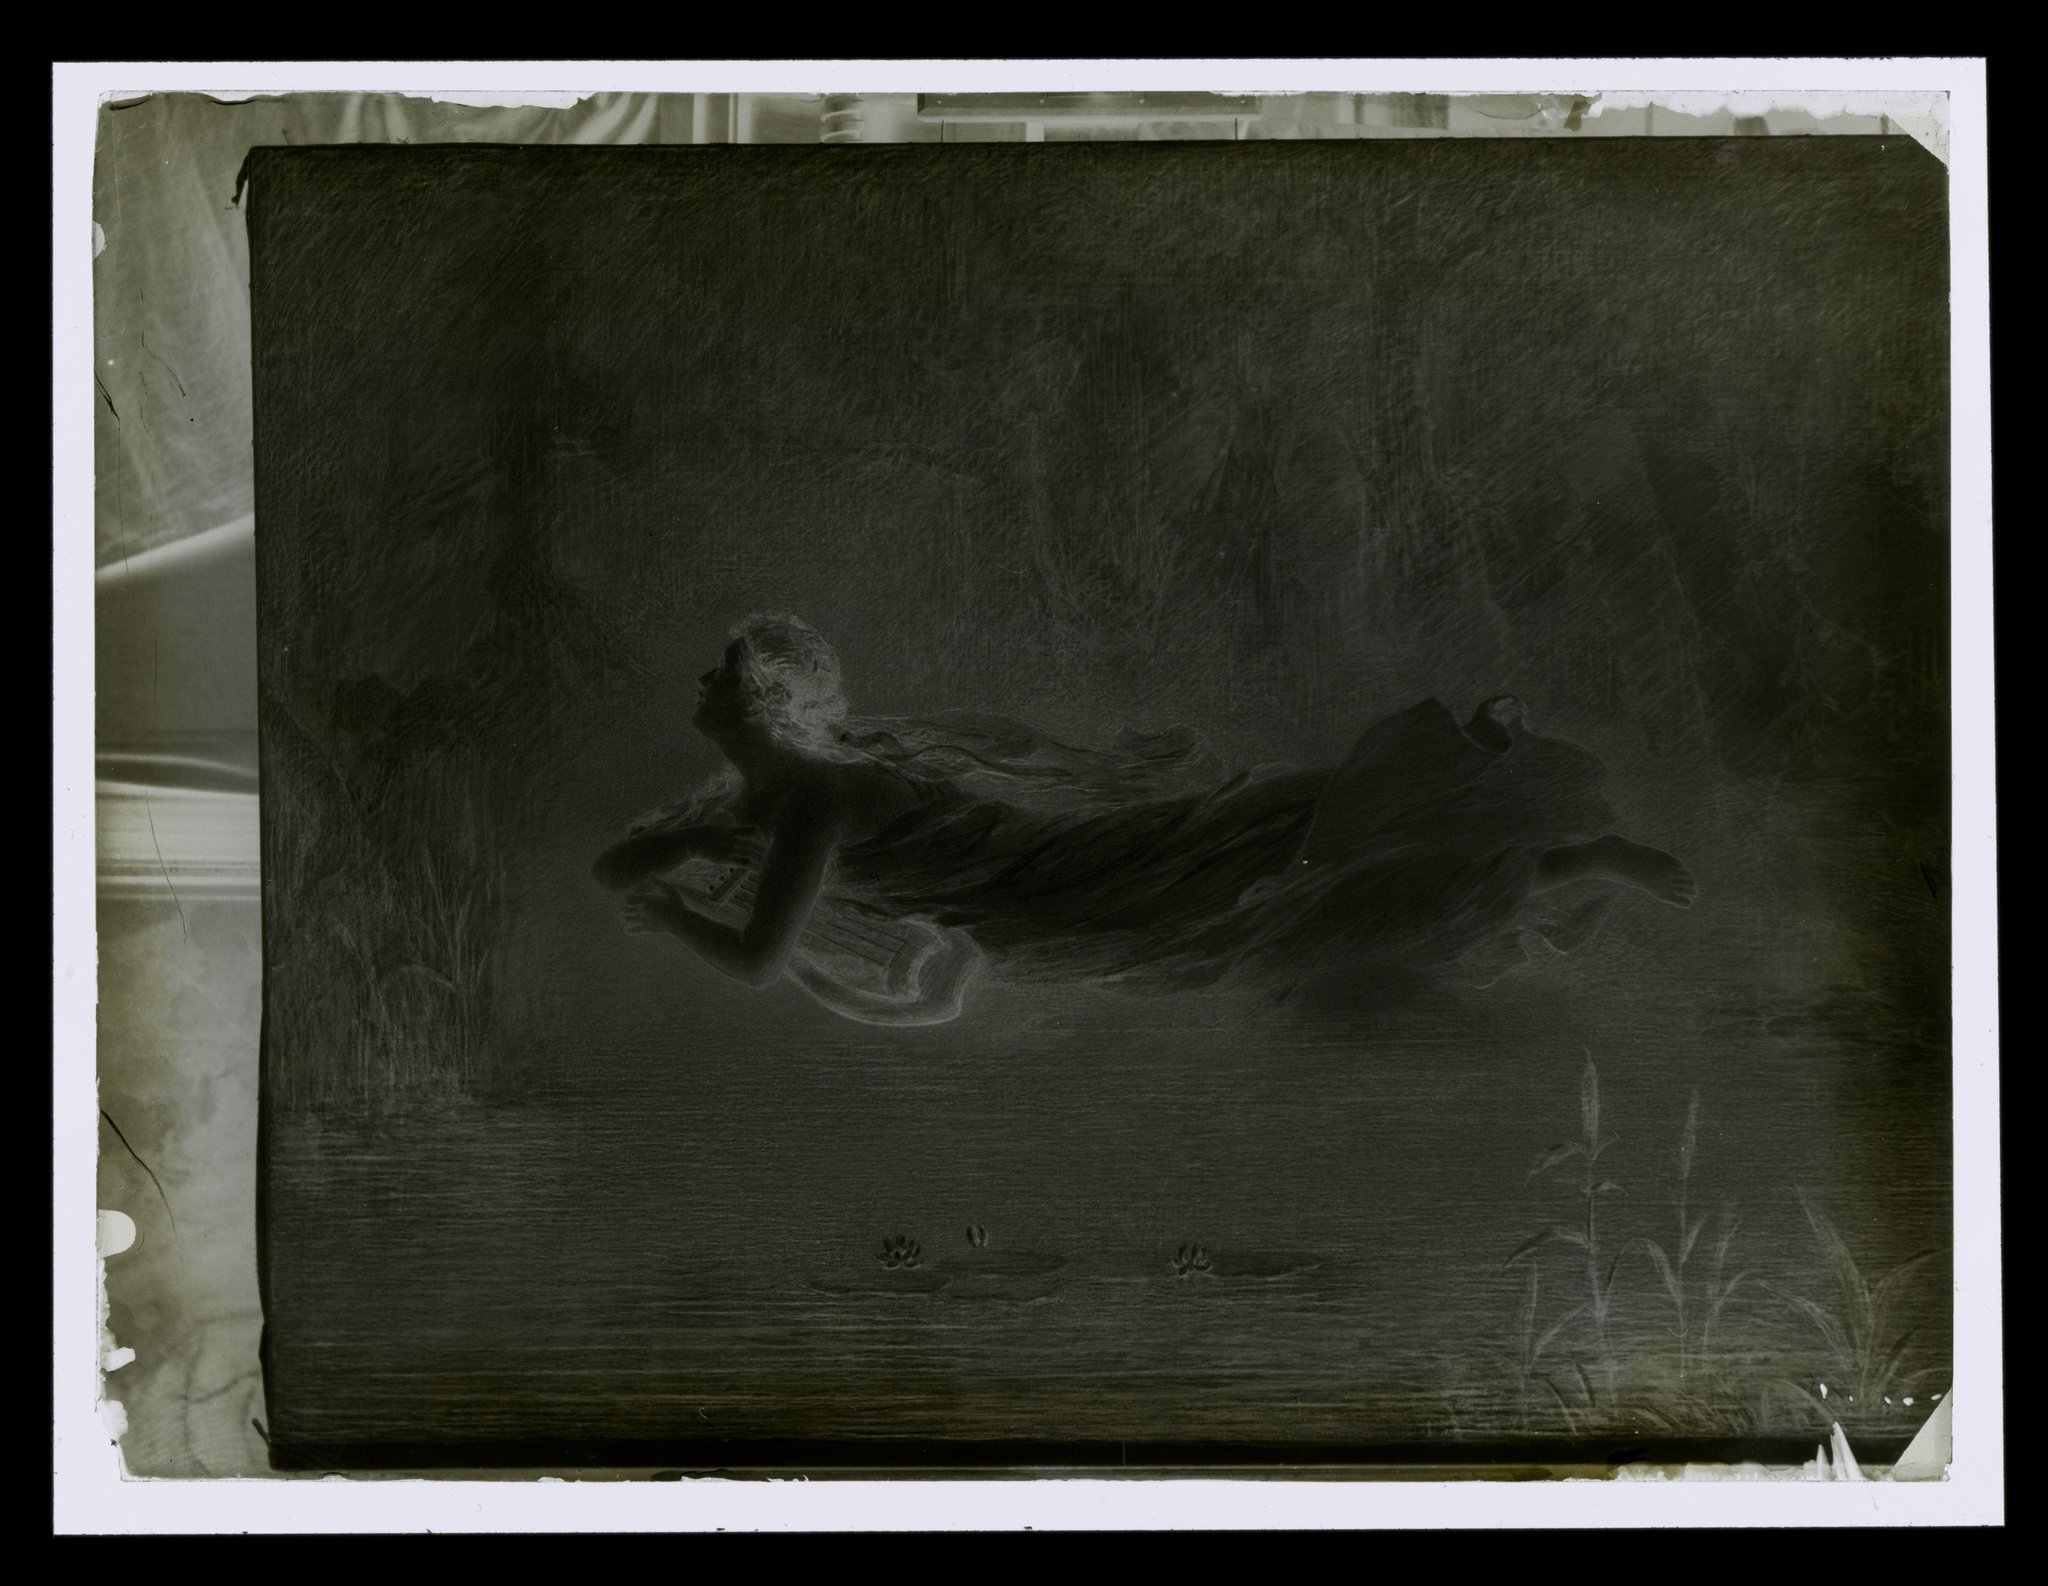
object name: glasnegatief, glasplaatnegatief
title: Fotoreproductie van een schilderij van een liggende vrouw met lier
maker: laurens lodewijk kleijn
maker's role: draughtsman, painter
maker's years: 1826-1909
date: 1865-1900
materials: glass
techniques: collodion process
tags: lyre, cithara, psaltery, picture, painting, lying figure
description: Onderdeel van groep glasnegatieven uit de nalatenschap van de schilder Laurens Lodewijk Kleijn, stillevens, portretten, zelfportretten en kunstreproducties.